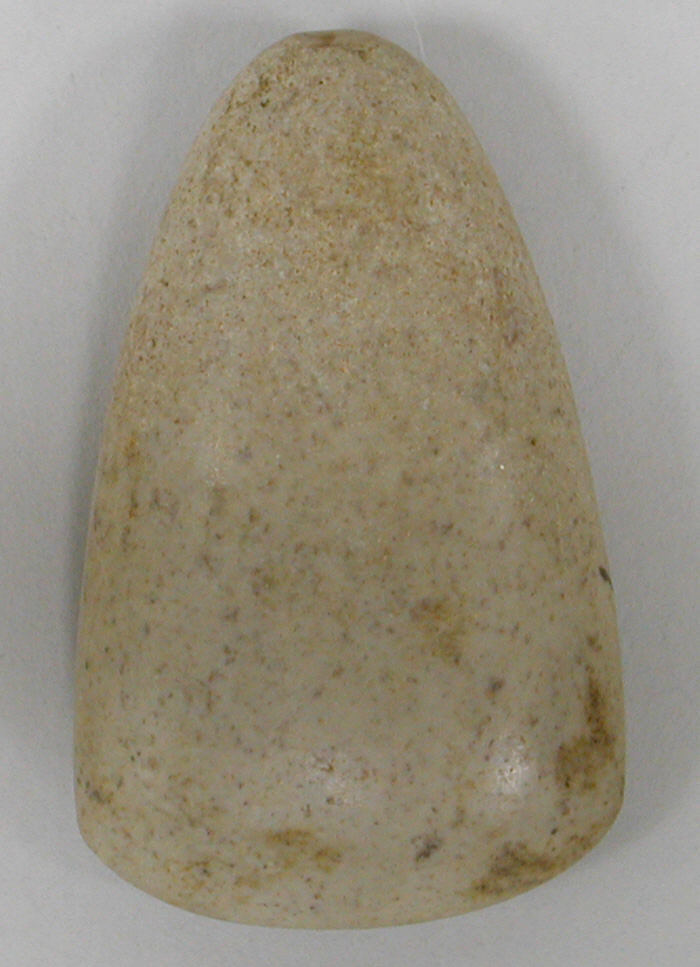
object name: celt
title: Stone Celt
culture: costa rican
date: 1501-1600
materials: stone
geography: costa rica